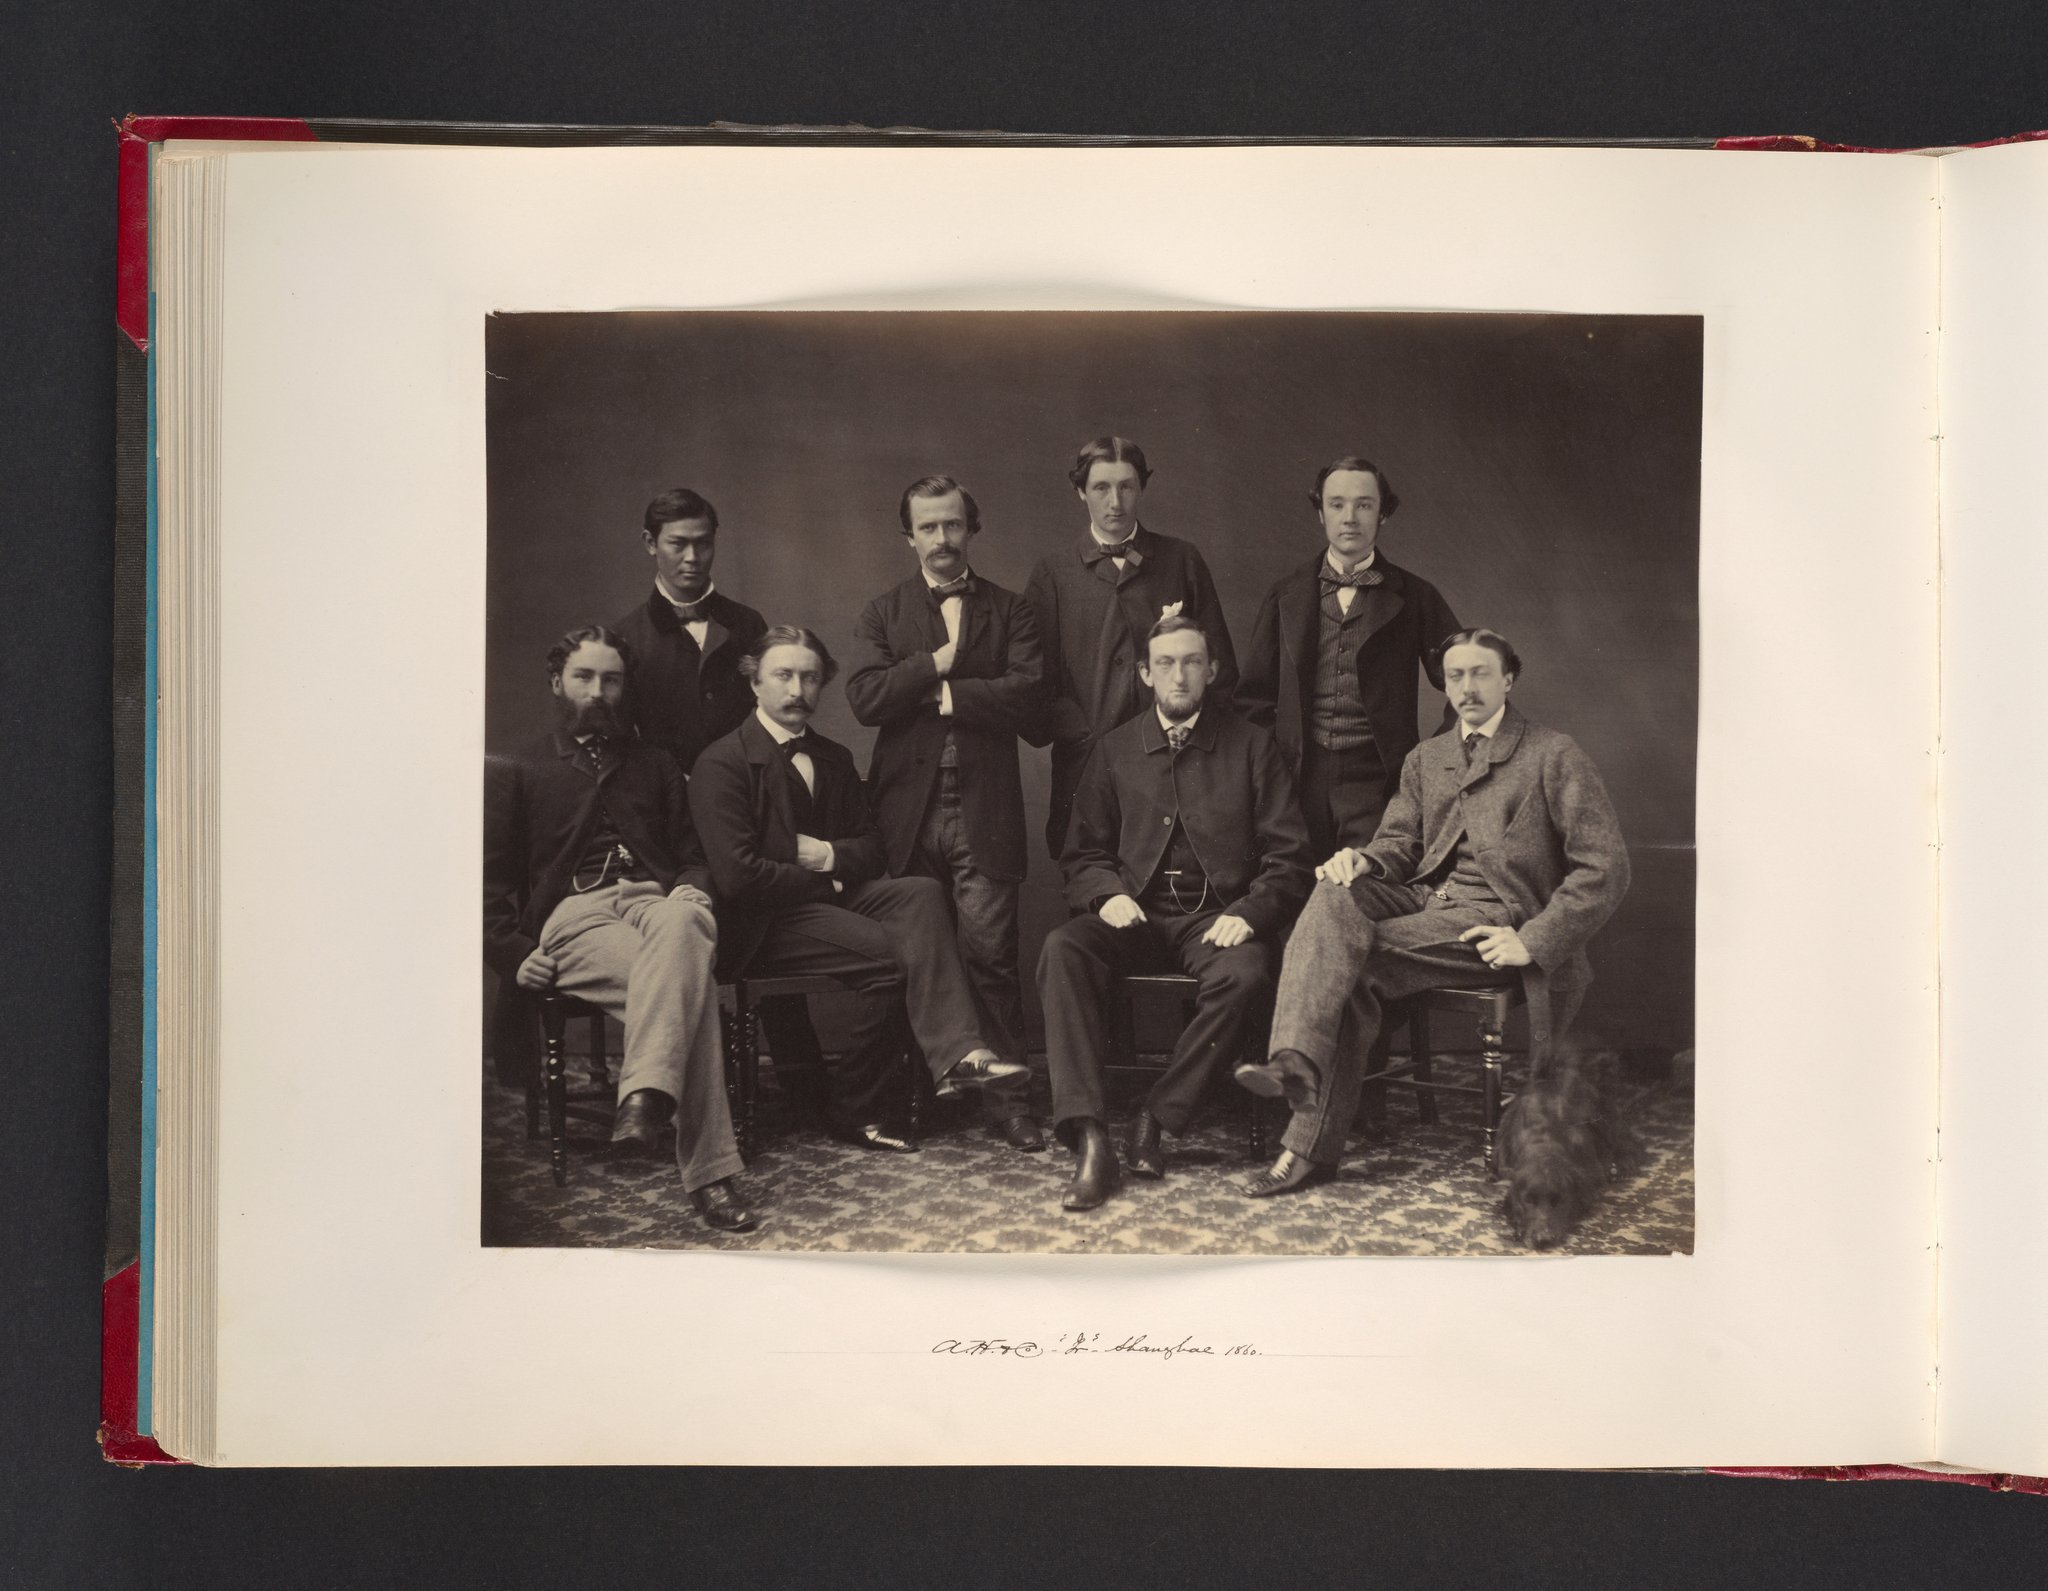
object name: photograph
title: Augustine Heard & Co., Shanghai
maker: john thomson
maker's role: artist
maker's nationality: british, scottish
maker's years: 1837-1921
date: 1860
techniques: albumen silver print, glass negative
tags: men,portraits